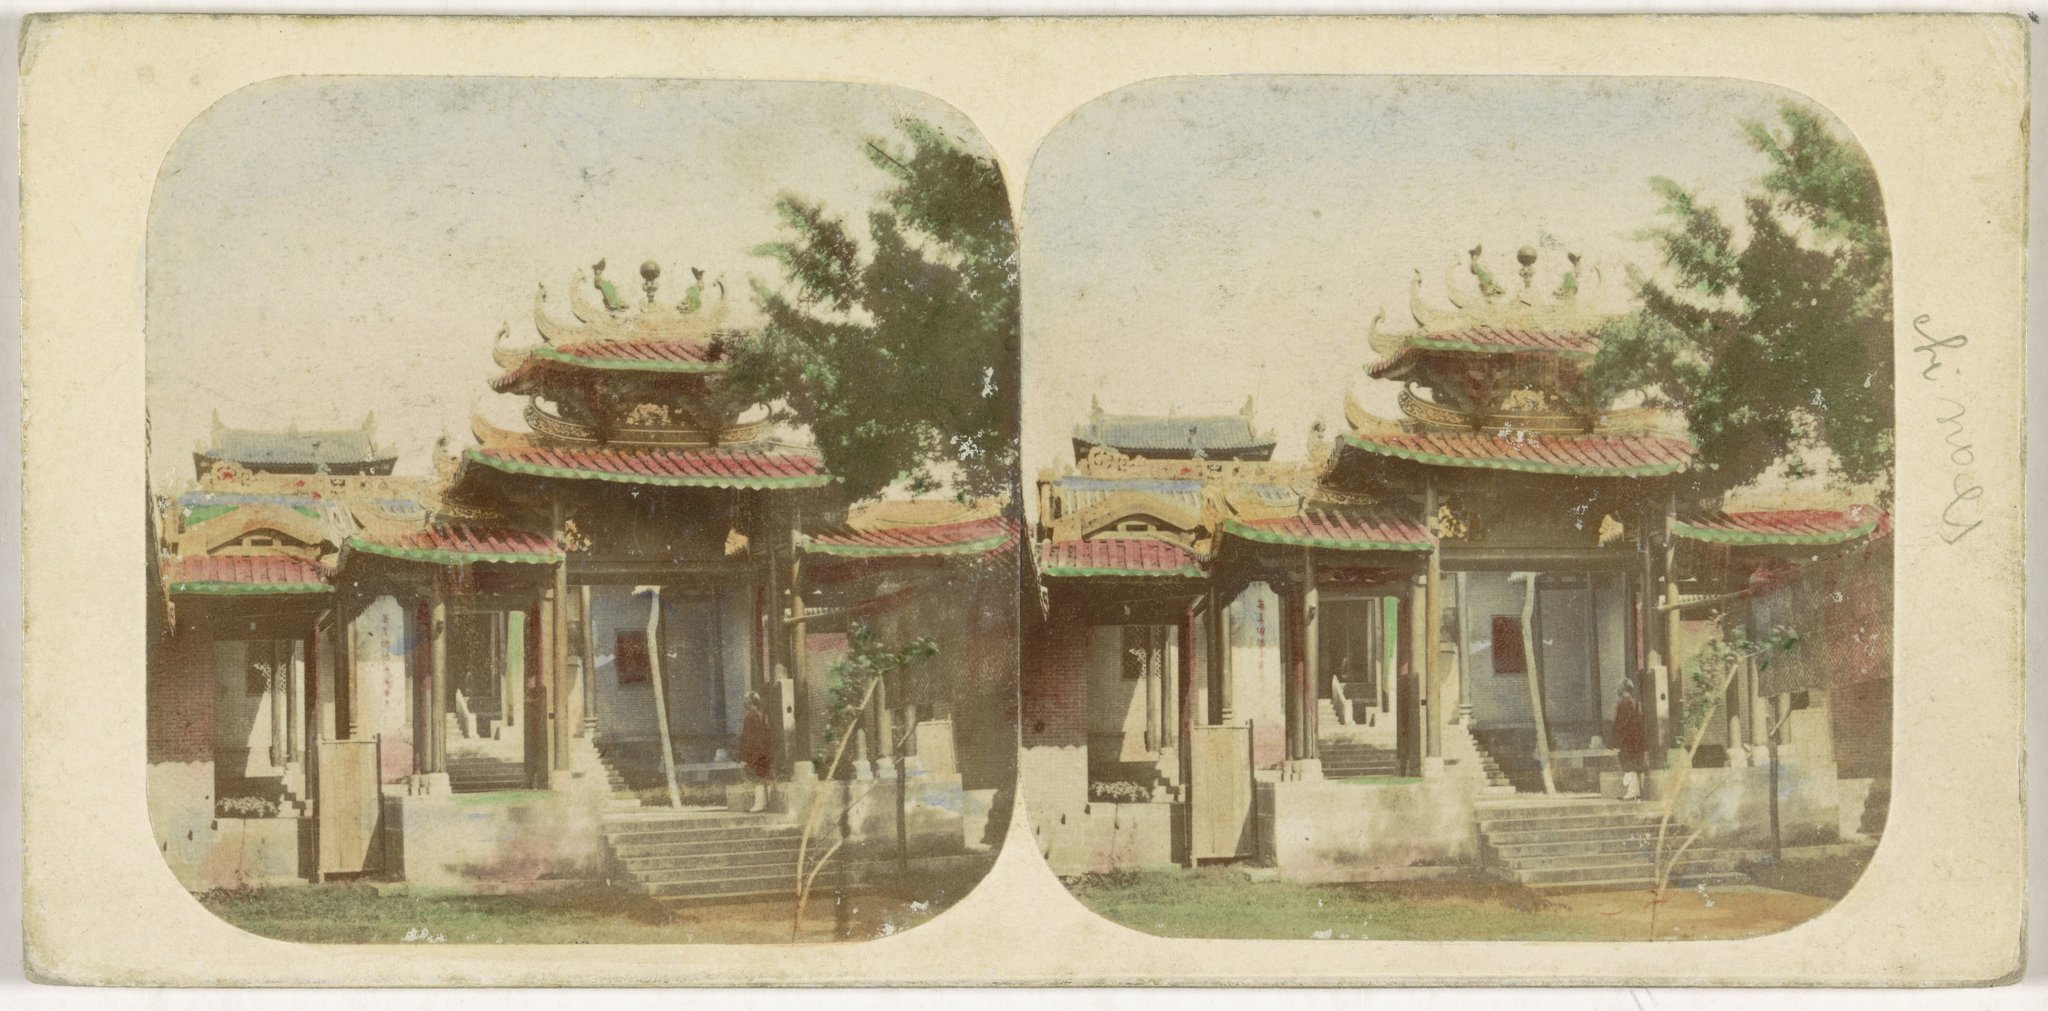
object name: stereograph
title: Views in China Canton. The Temple of the Five Gennii...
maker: felice beato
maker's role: fotograaf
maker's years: 1825-1909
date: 1850-1860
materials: photographic support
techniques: albumen print, hand coloring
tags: kanton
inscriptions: title: ‘Views in China. 8 Canton. The Temple of the Five Gennii...’, annotation: ‘chi noch’